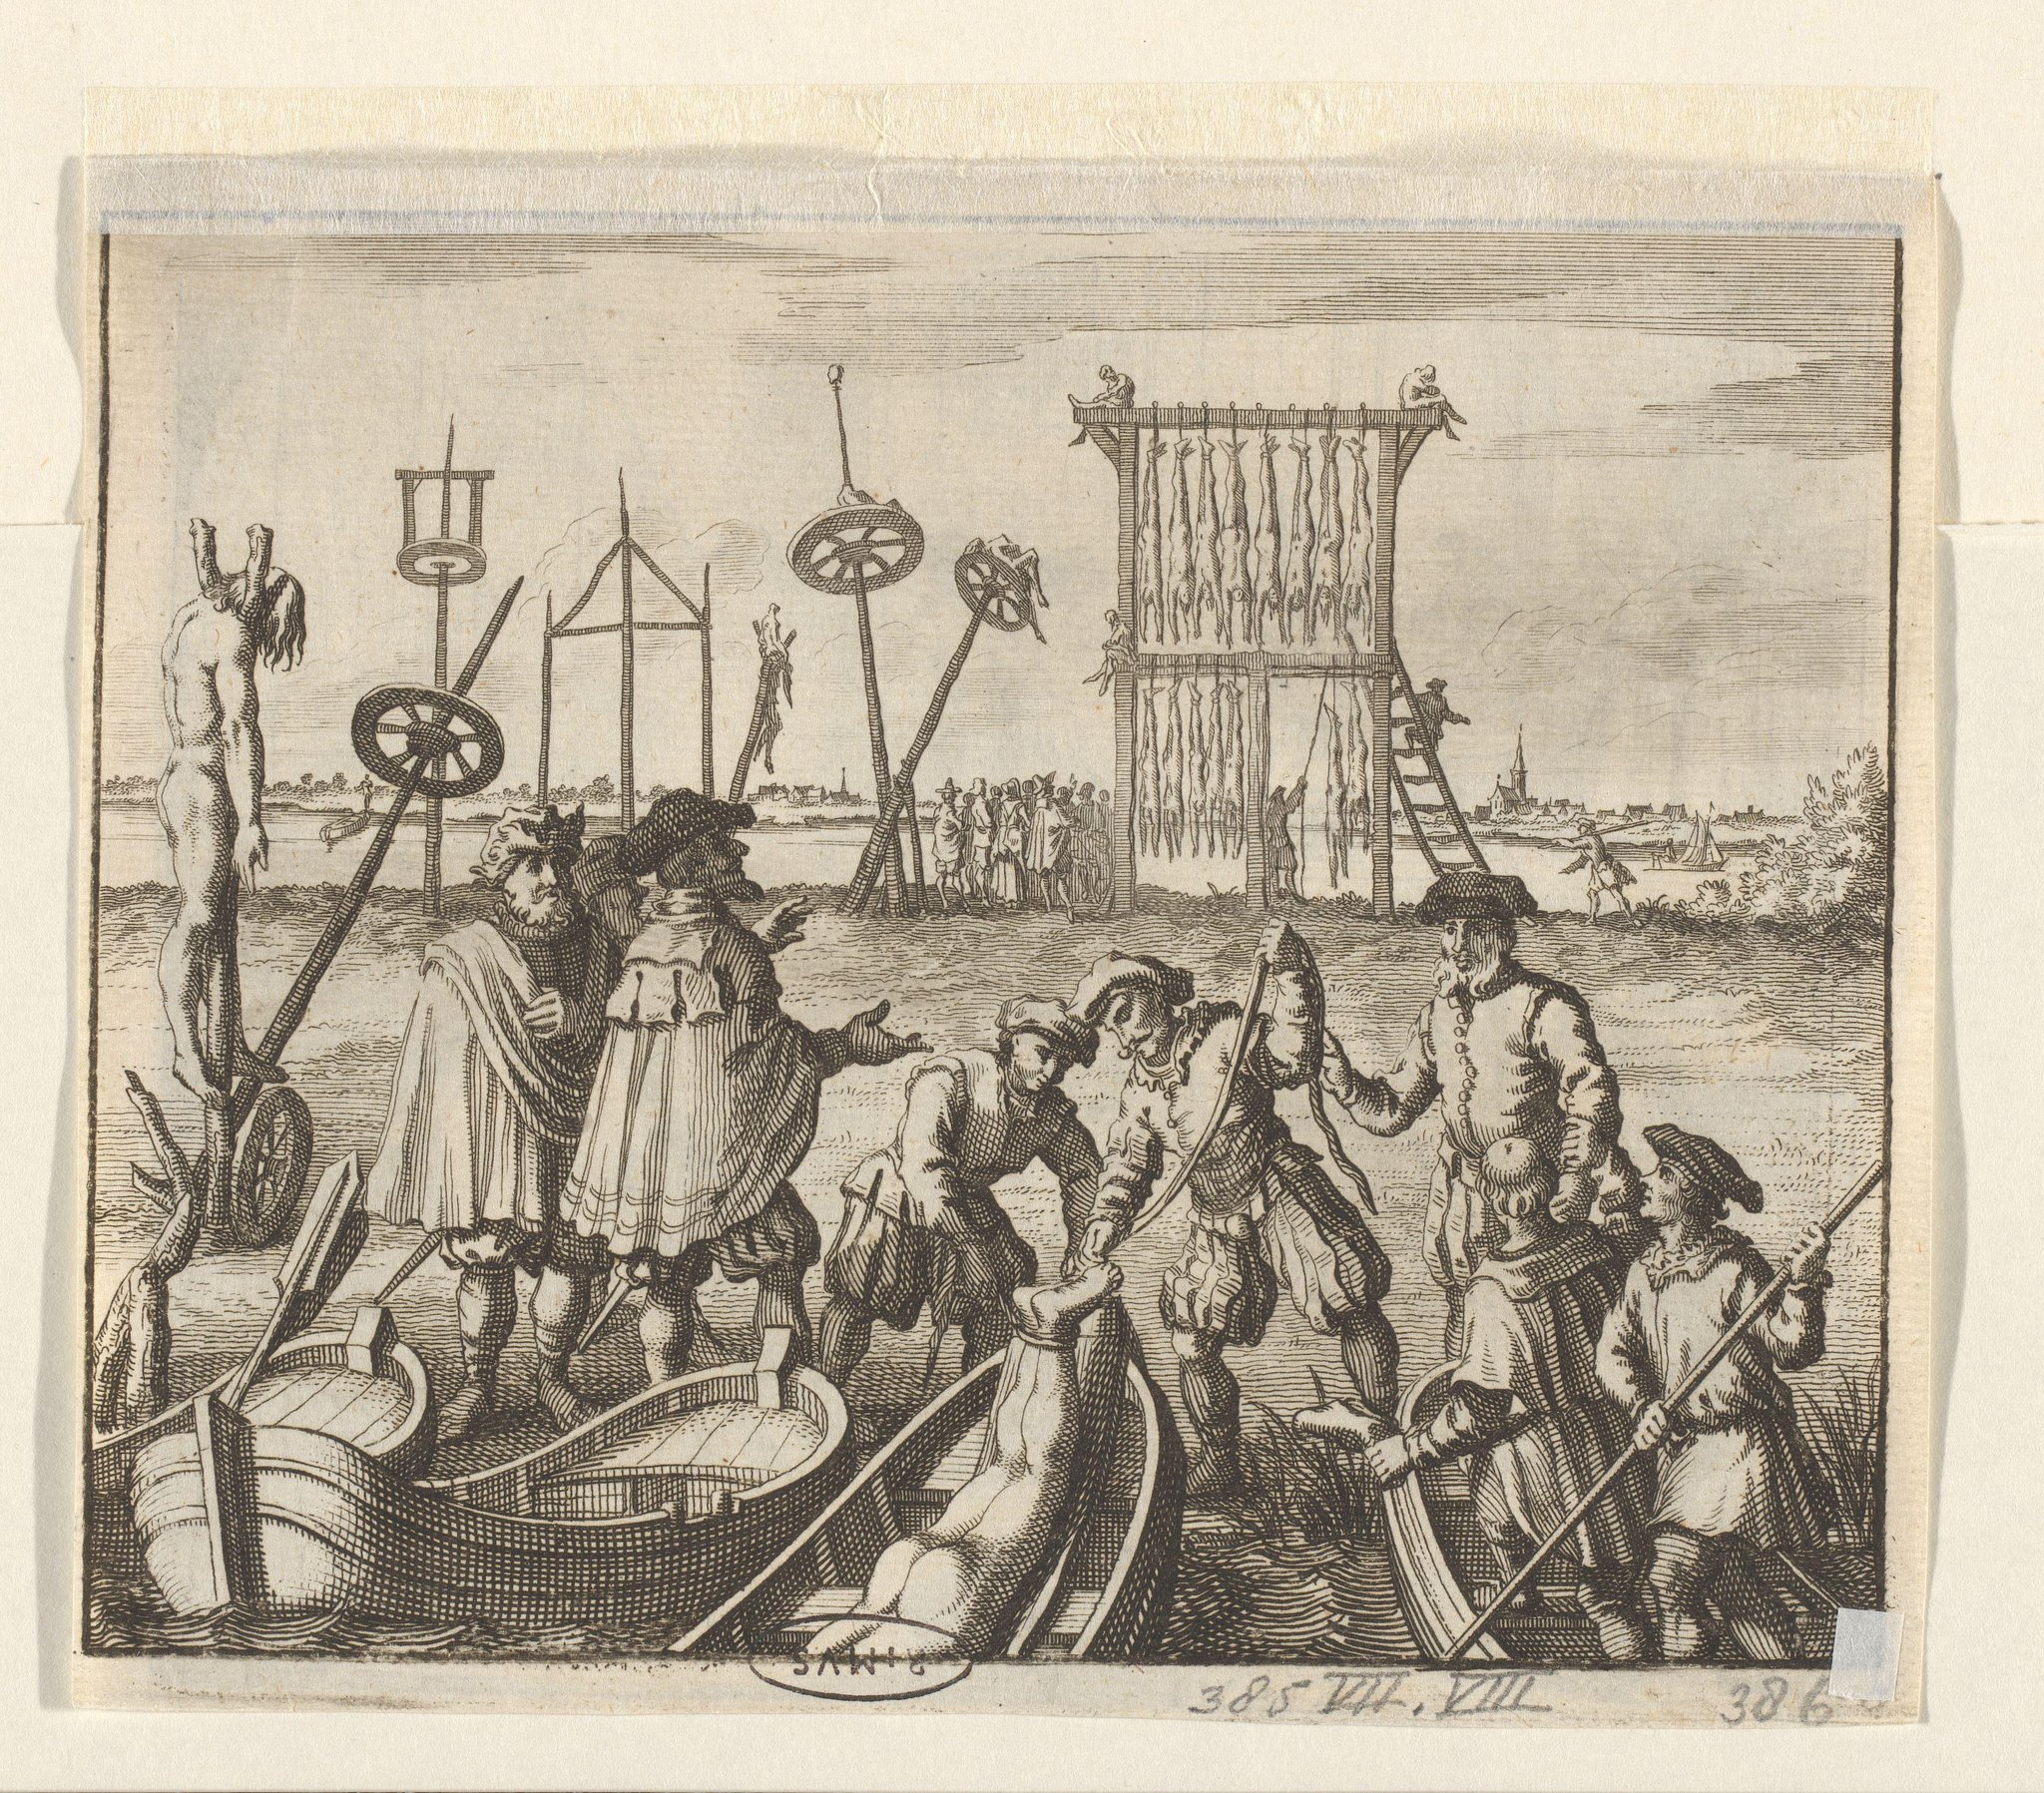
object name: print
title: De lijken van de wederdopers op het galgenveld, 1535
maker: Anonymous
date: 1662-1665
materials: paper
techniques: engraving, etching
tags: body of the executed displayed in public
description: Gebruikt als illustratie in: T. van Domselaer, Beschryvinge van Amsterdam, Marcus Willemsz Doornick, Amsterdam 1665, VI. Boeck, p. 175. Deze prenten zijn gebaseerd op de anonieme gravures in de eerste uitgave Hortensius' Van den oproer der weder-dooperen uit 1614. Kopieën naar FMH 386, Niet in Frederik Muller; door het RPK toegevoegd nummer.